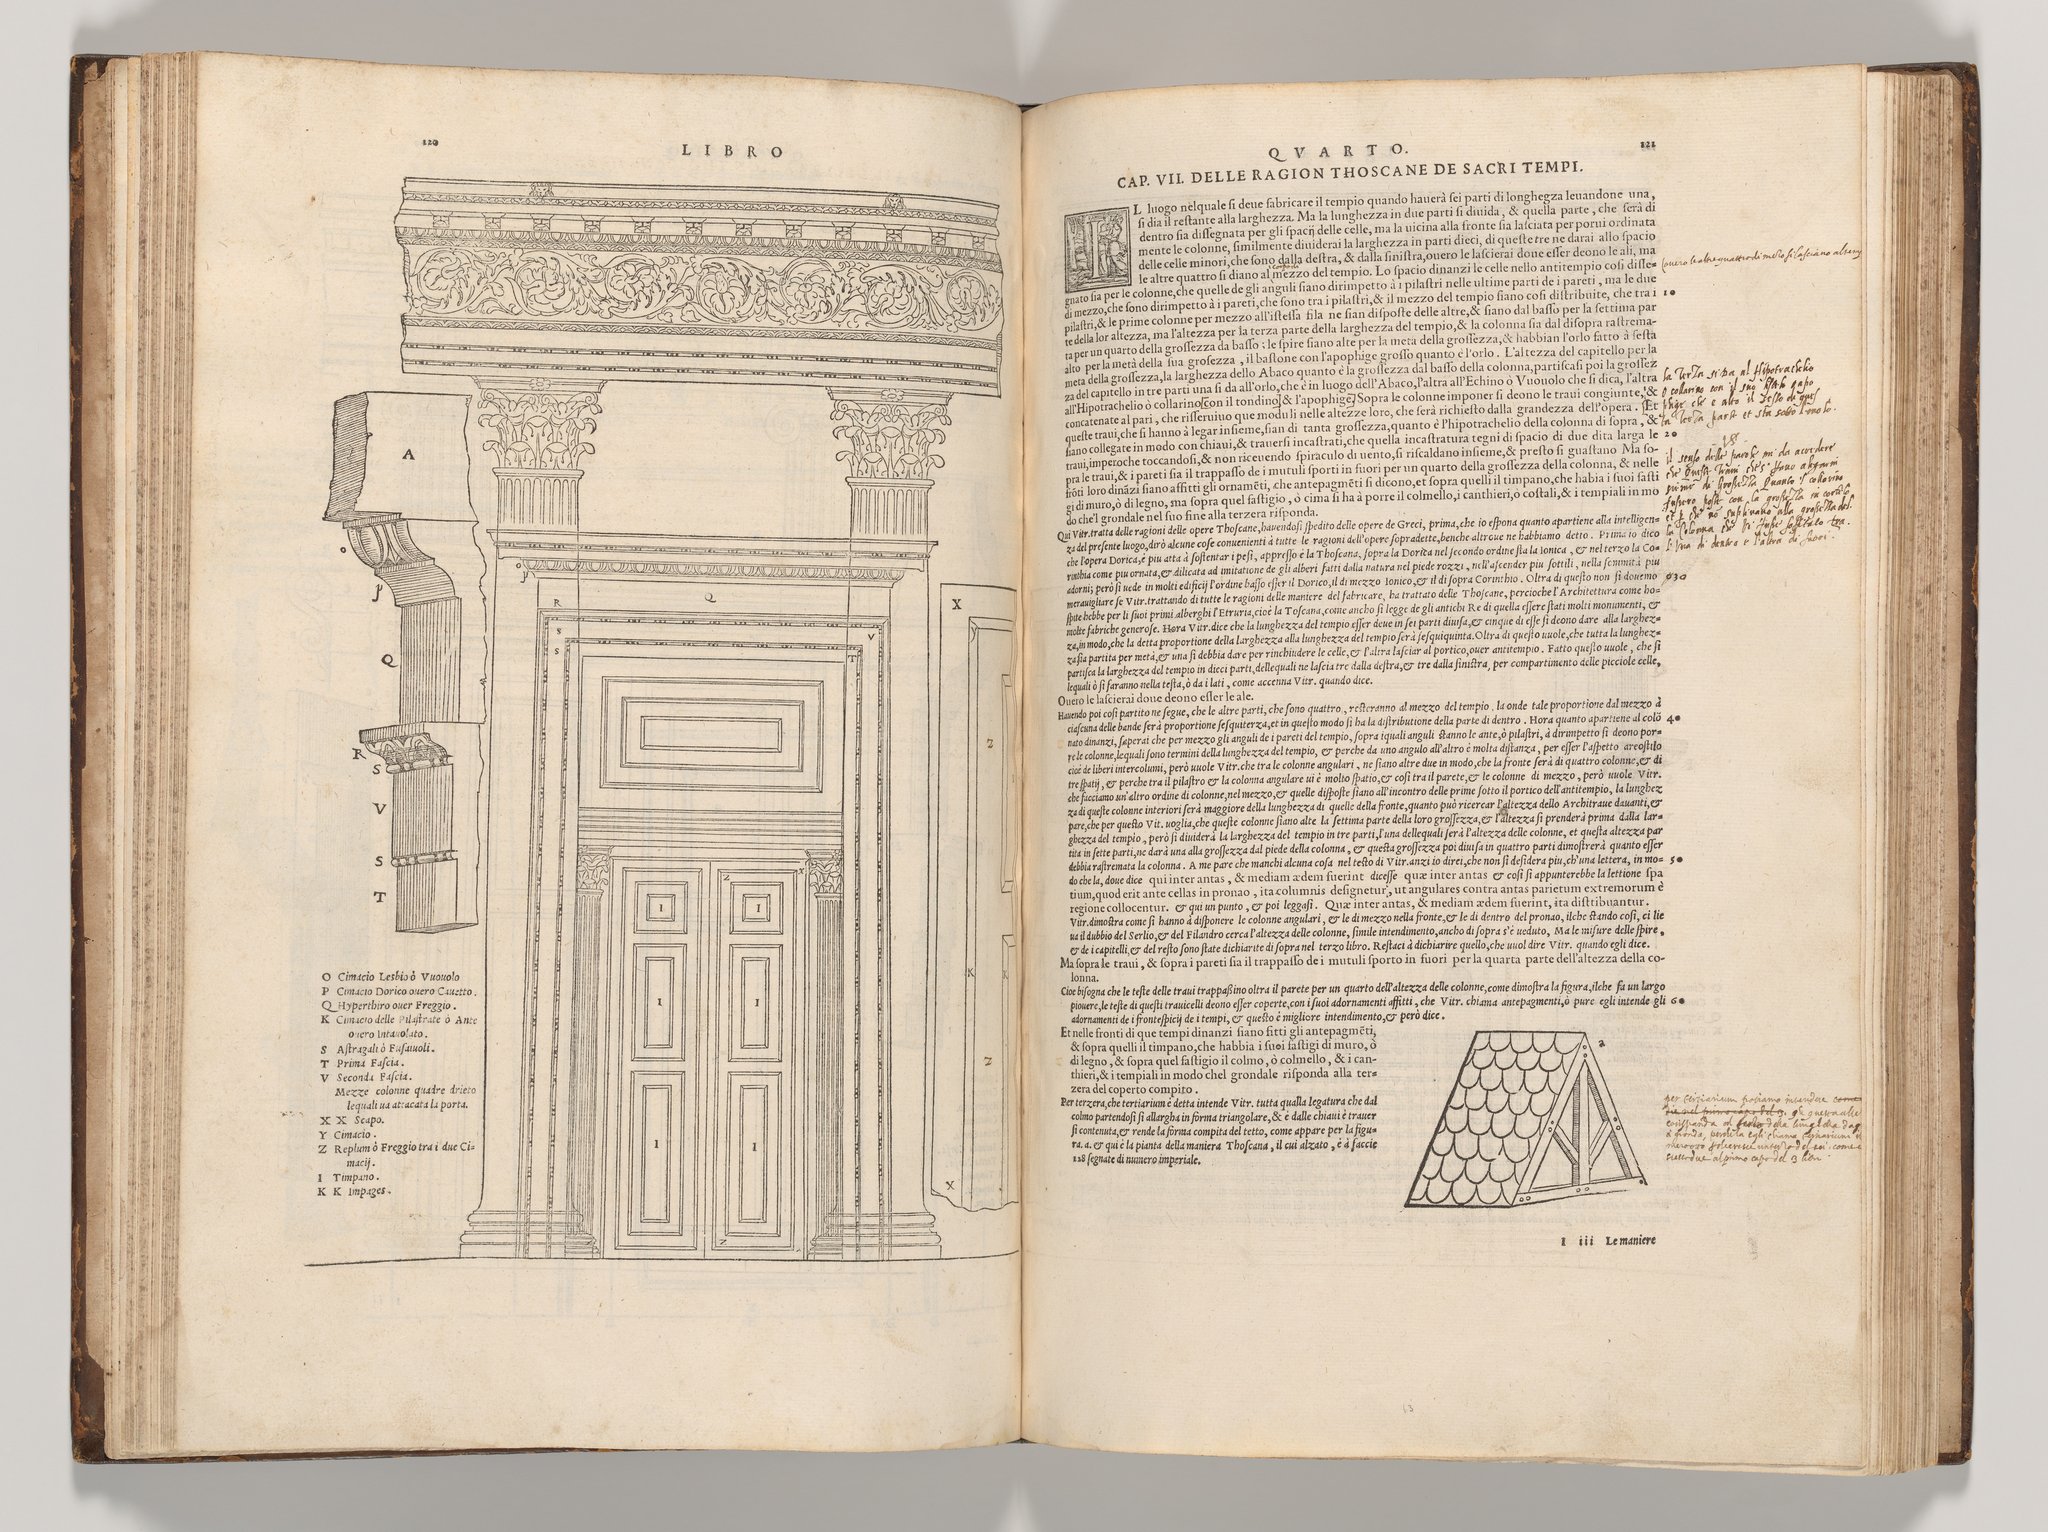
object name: book print ornament architecture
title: I dieci libri dell'architettura di M. Vitruvio tradutti et commentati da monsignor Barbaro eletto patriarca d'aquileggia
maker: marcus pollio vitruvius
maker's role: author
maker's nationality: italian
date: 1556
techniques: printing, woodcut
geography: italy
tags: architecture